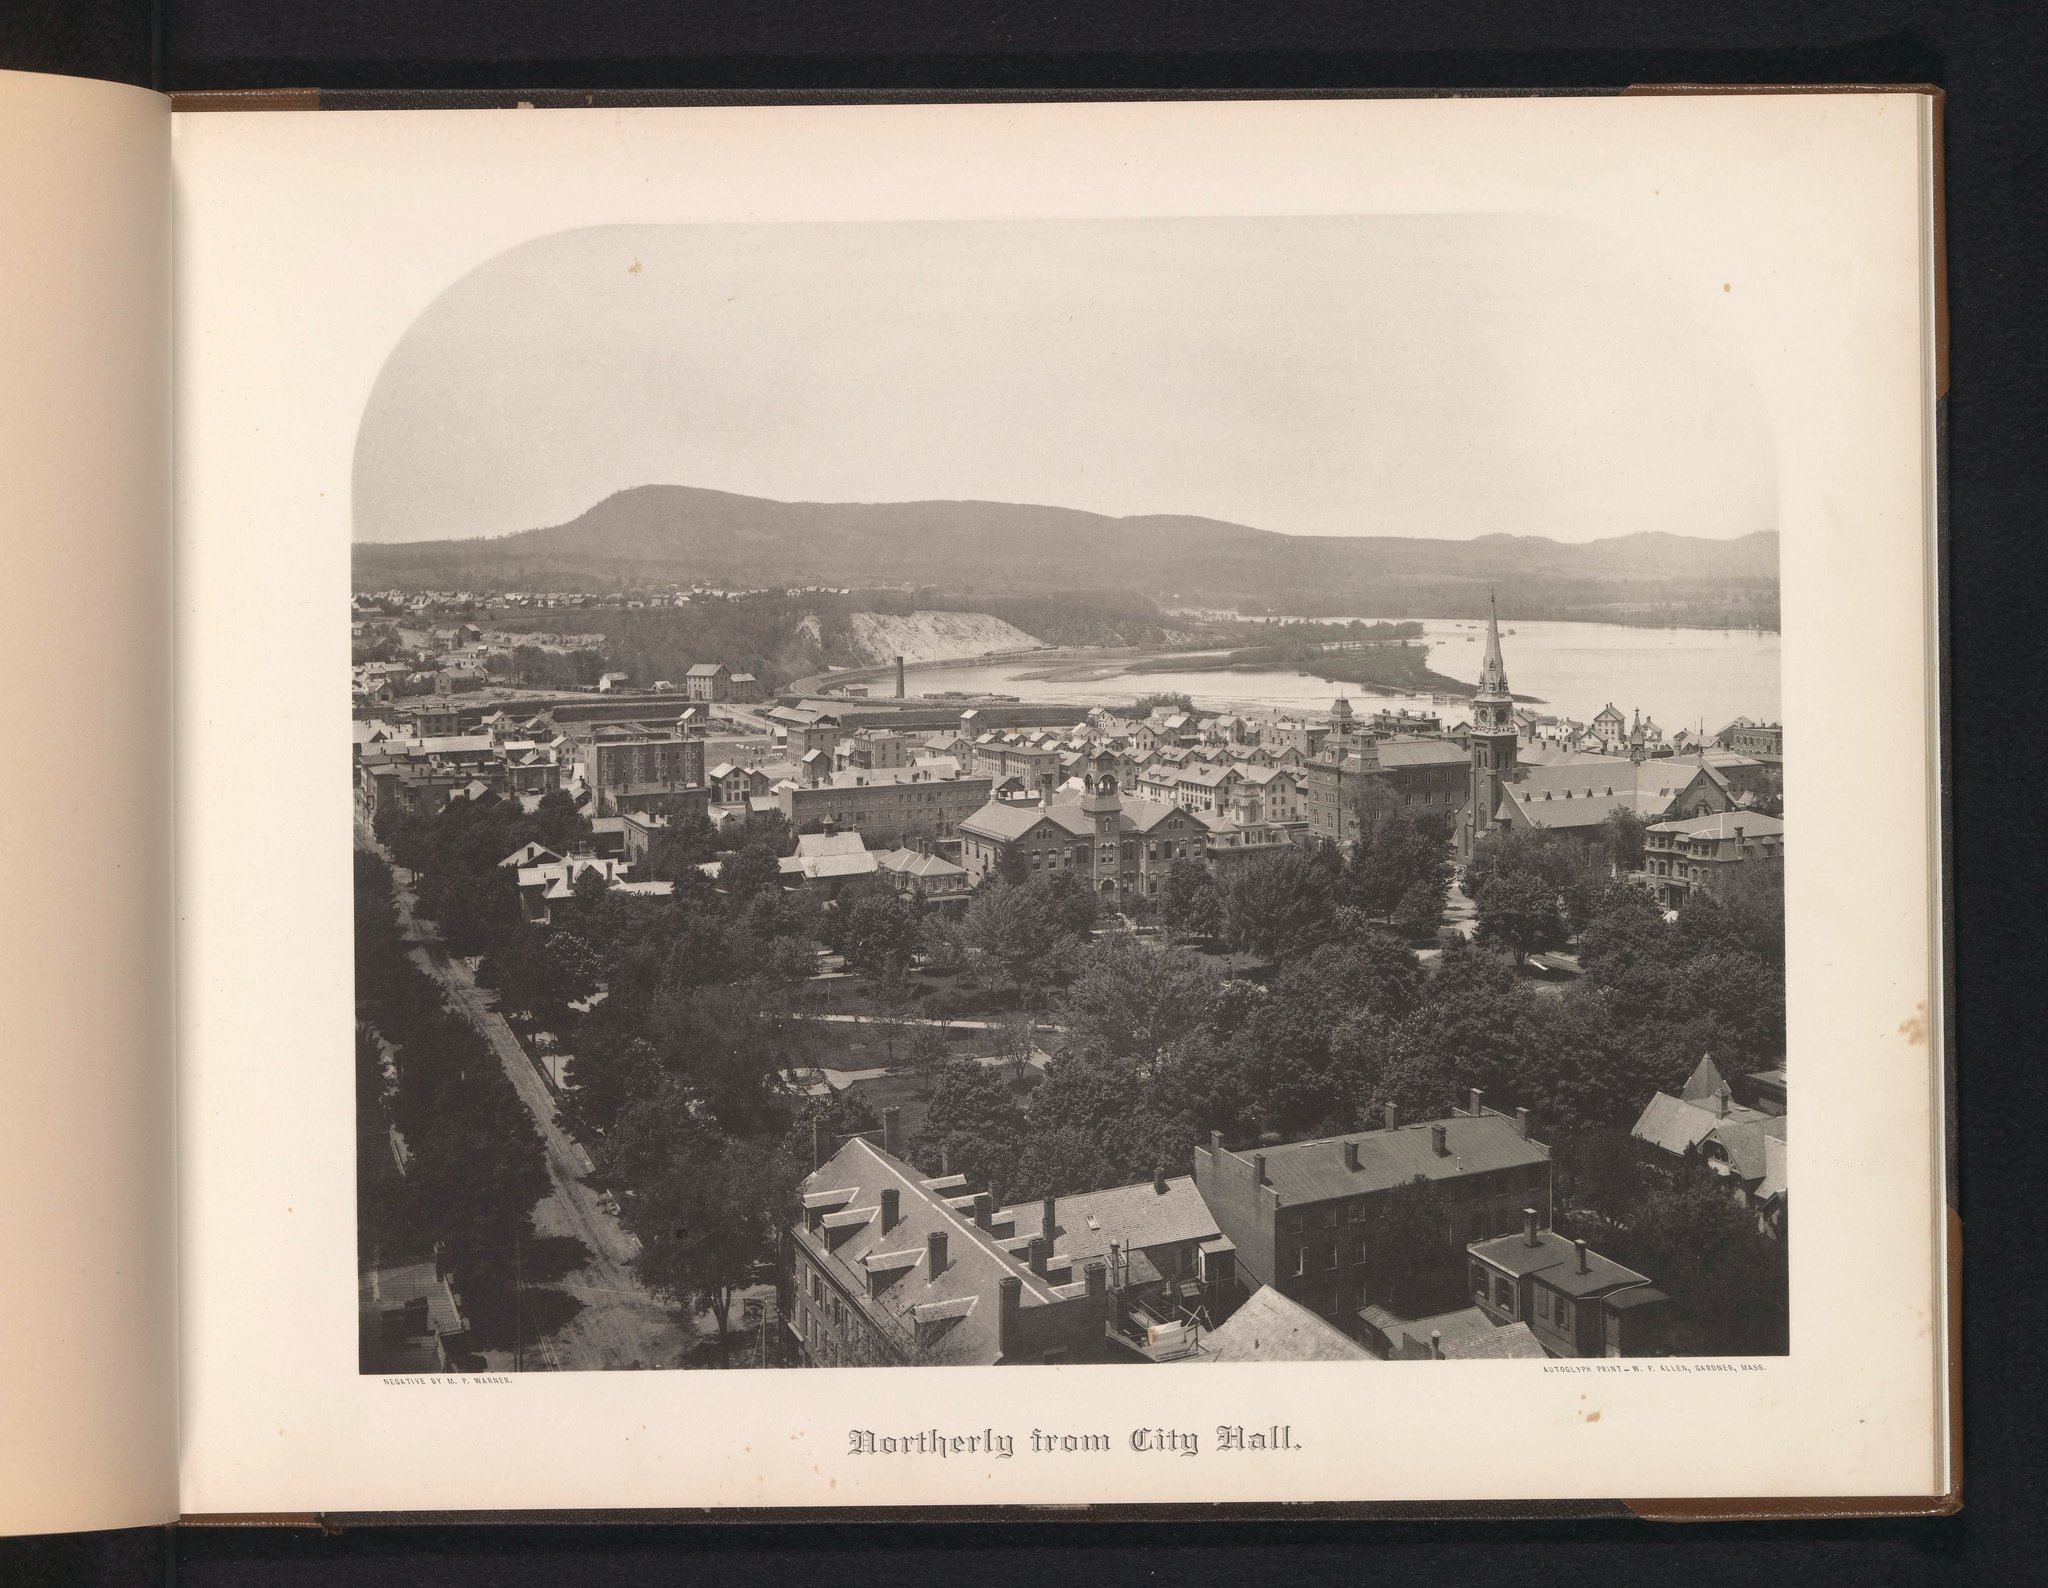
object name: page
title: Northerly from City Hall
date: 1883-1888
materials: paper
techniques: photograph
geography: massachusetts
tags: city-view in general; 'veduta'